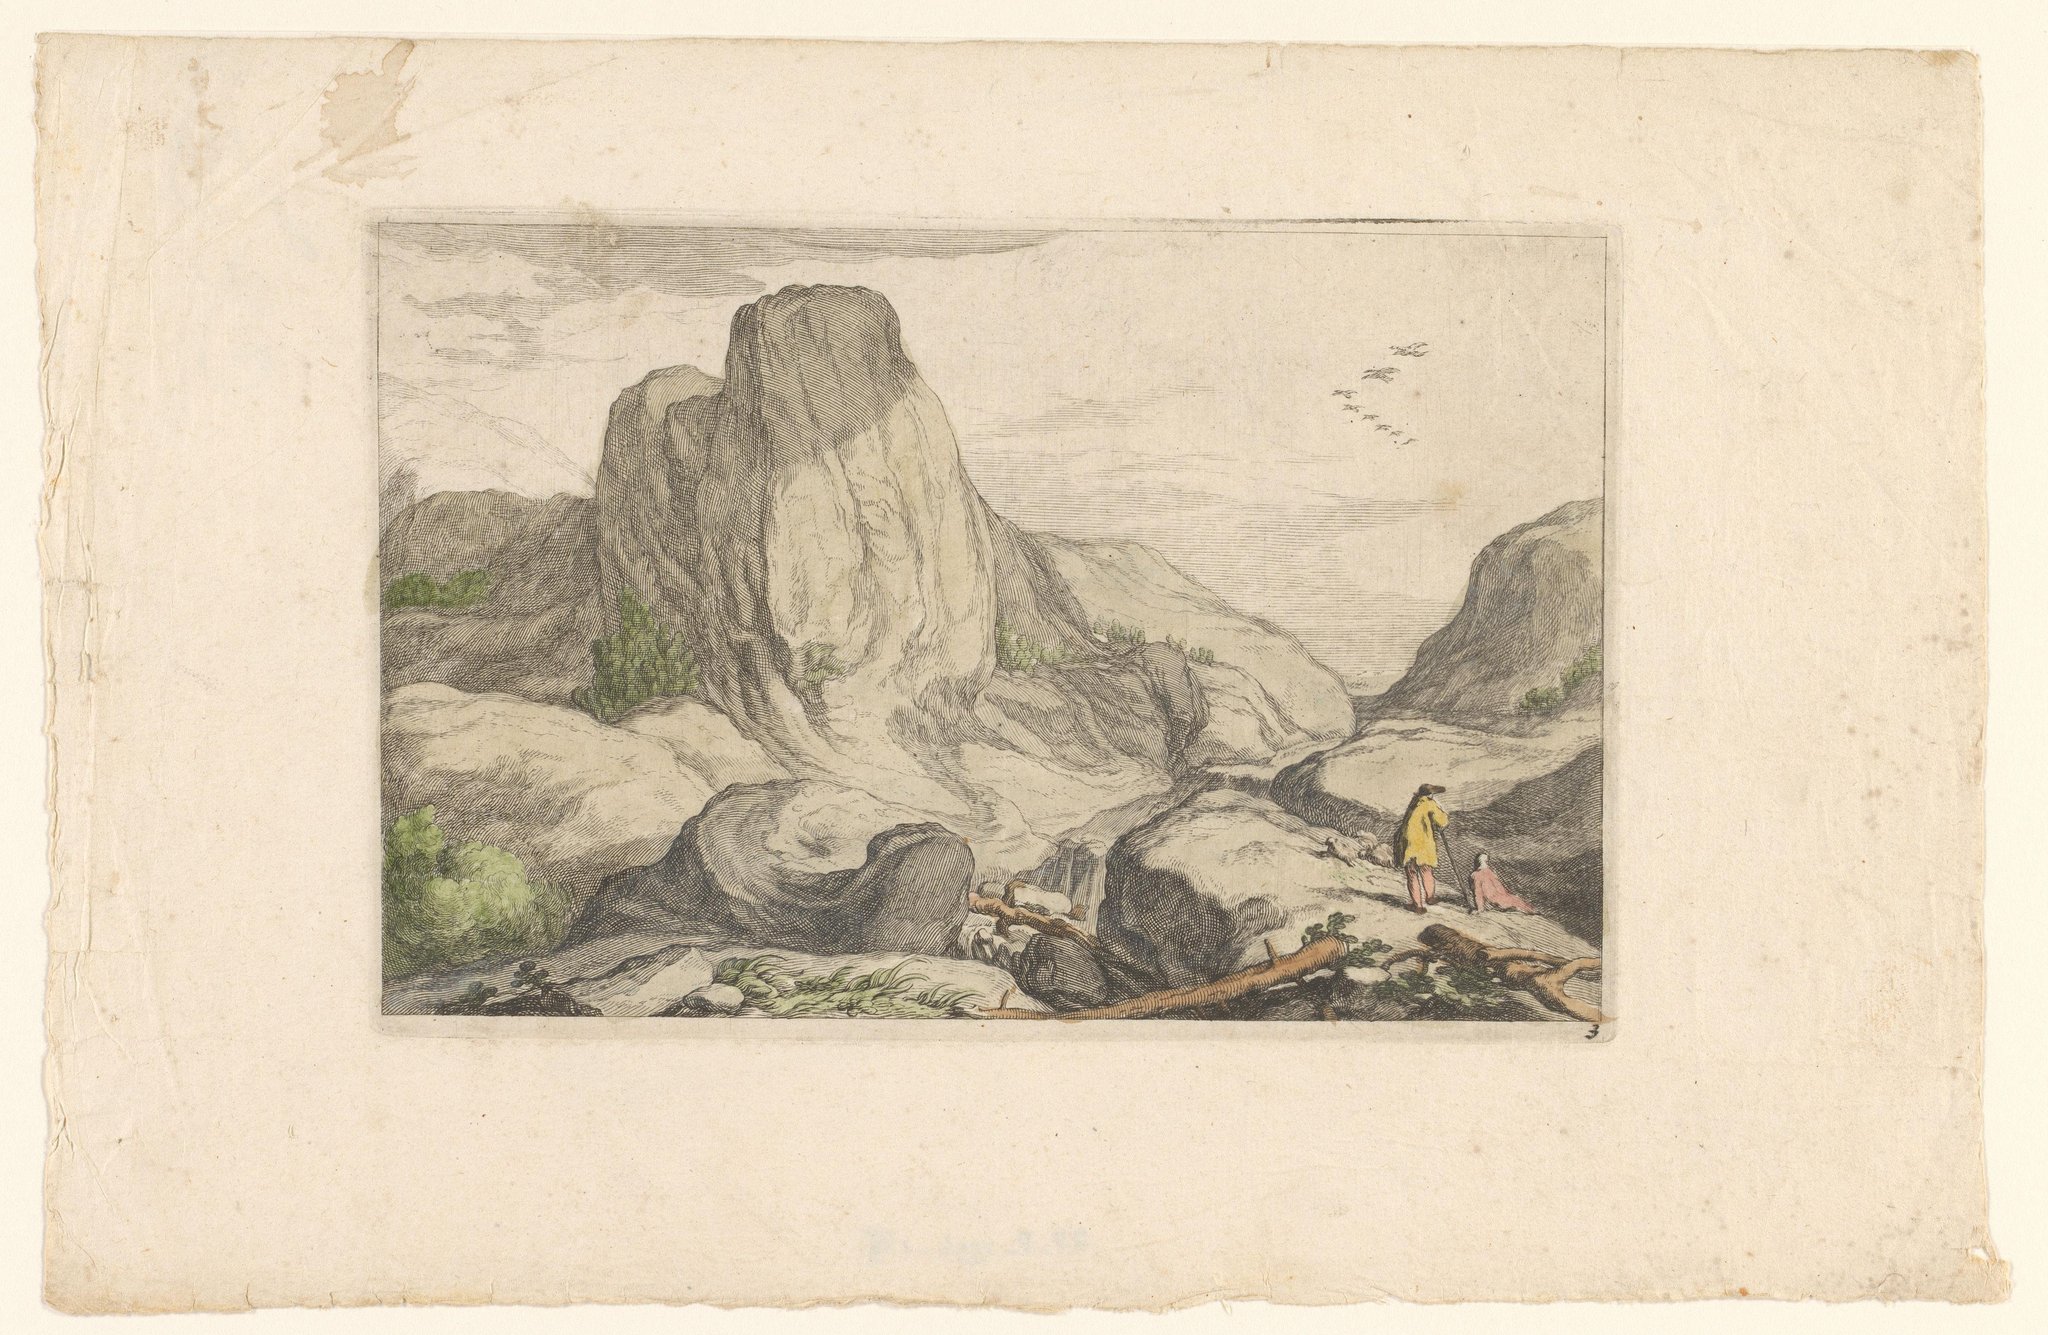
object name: print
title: Elf landschappen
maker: frederick bloemaert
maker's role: print maker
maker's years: 1614-1669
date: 1635-1669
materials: paper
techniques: engraving, etching, hand coloring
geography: netherlands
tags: herding, herdsman, herdswoman, shepherd, shepherdess, cowherd, etc., rock-formations